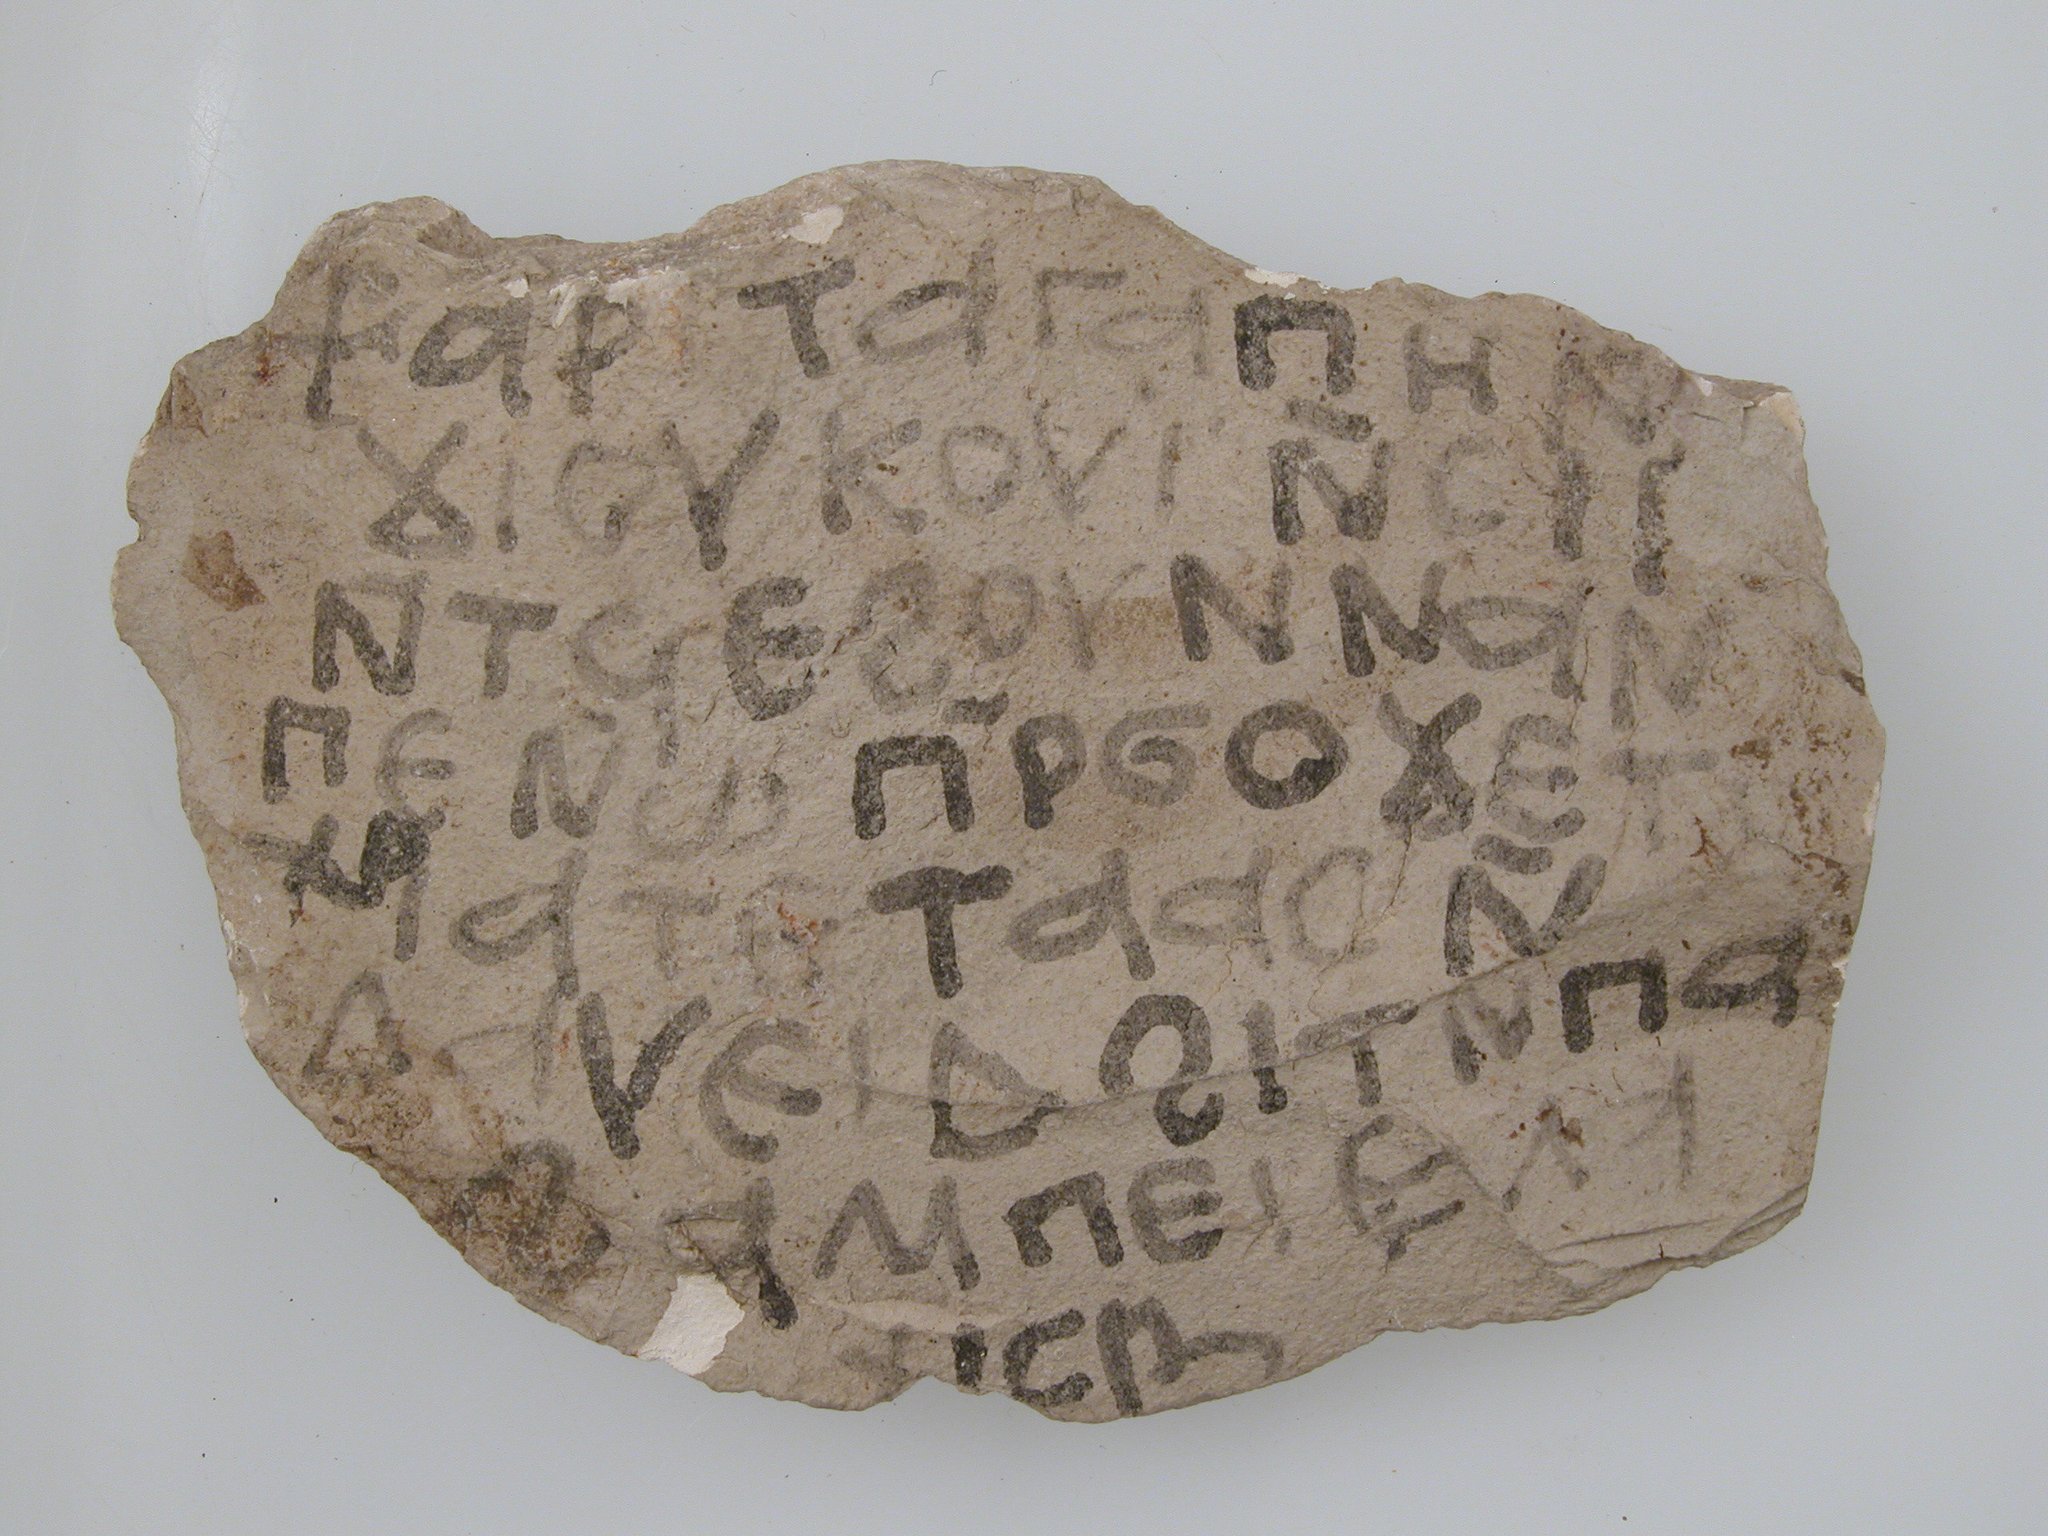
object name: ostrakon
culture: coptic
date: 601-700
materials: ink, limestone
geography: egypt